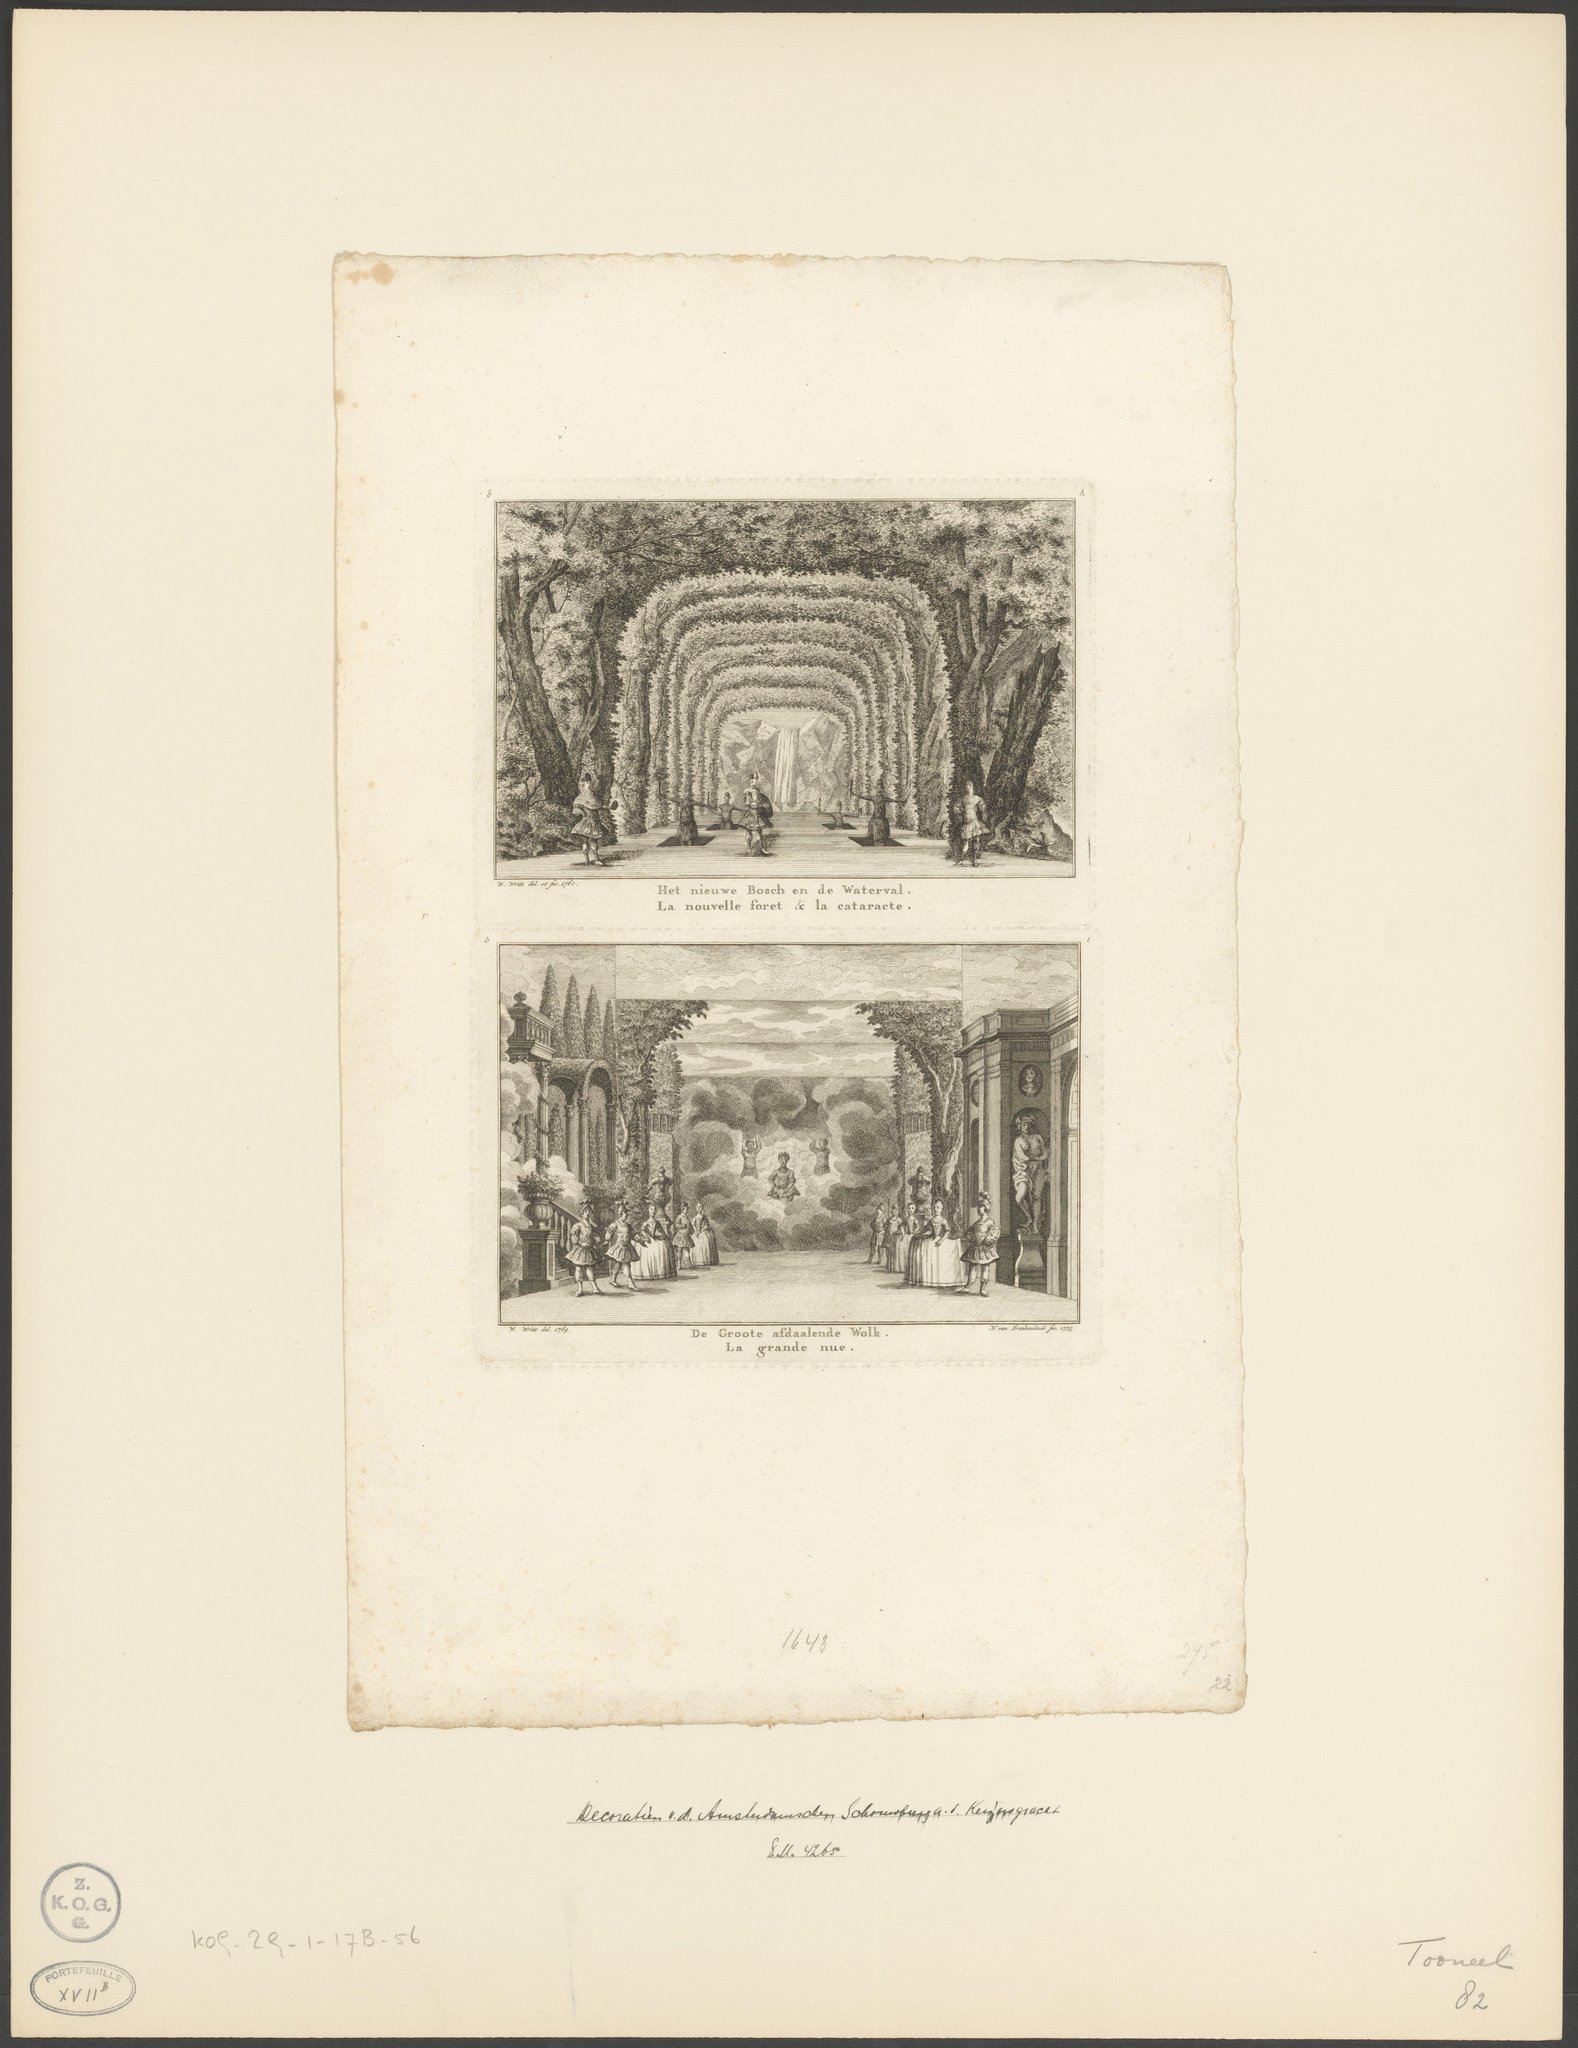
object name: print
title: De Groote afdaalende Wolk / La grande nue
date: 1760-1775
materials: paper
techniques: engraving, etching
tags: theatre, theatrical performance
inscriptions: stamp, collector's mark: Lugt 1641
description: Bovenaan de bovenste prent genummerd: b/h. Bovenaan de onderste prent genummerd: b/i. Onderwerpsrubrieken binnen de Atlas Zeden en Gewoonten: Schoone kunsten, Tooneel, Schouwburg op de Keizersgracht (1637 – 1772).